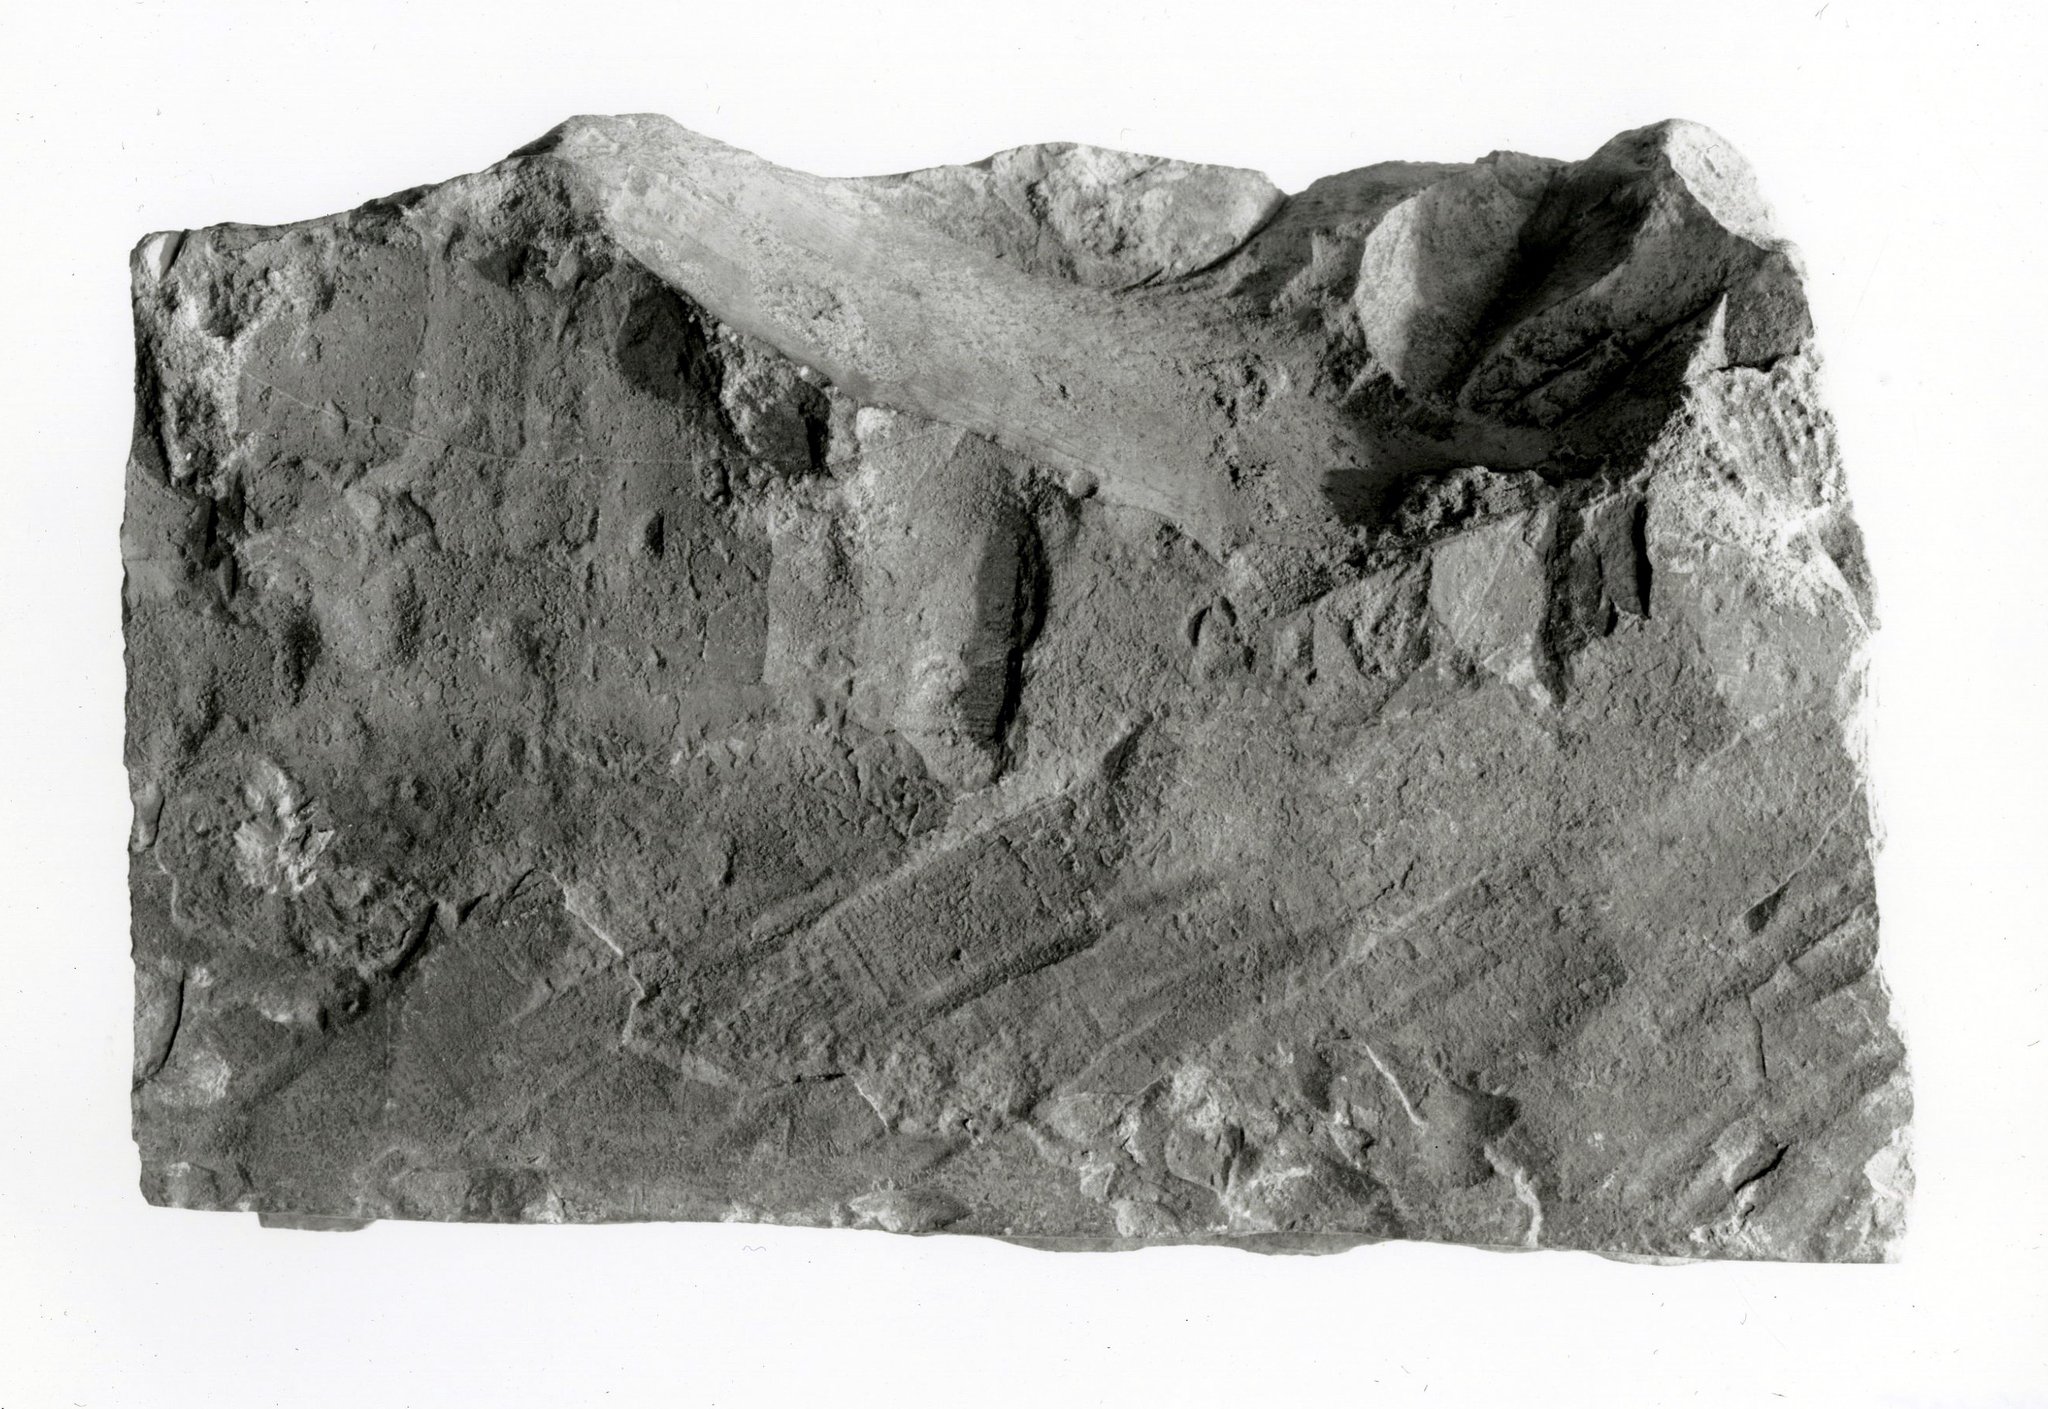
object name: relief, tomb of nespekashuty, wall casing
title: Wall casing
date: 664-610 BCE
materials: limestone, mortar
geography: egypt